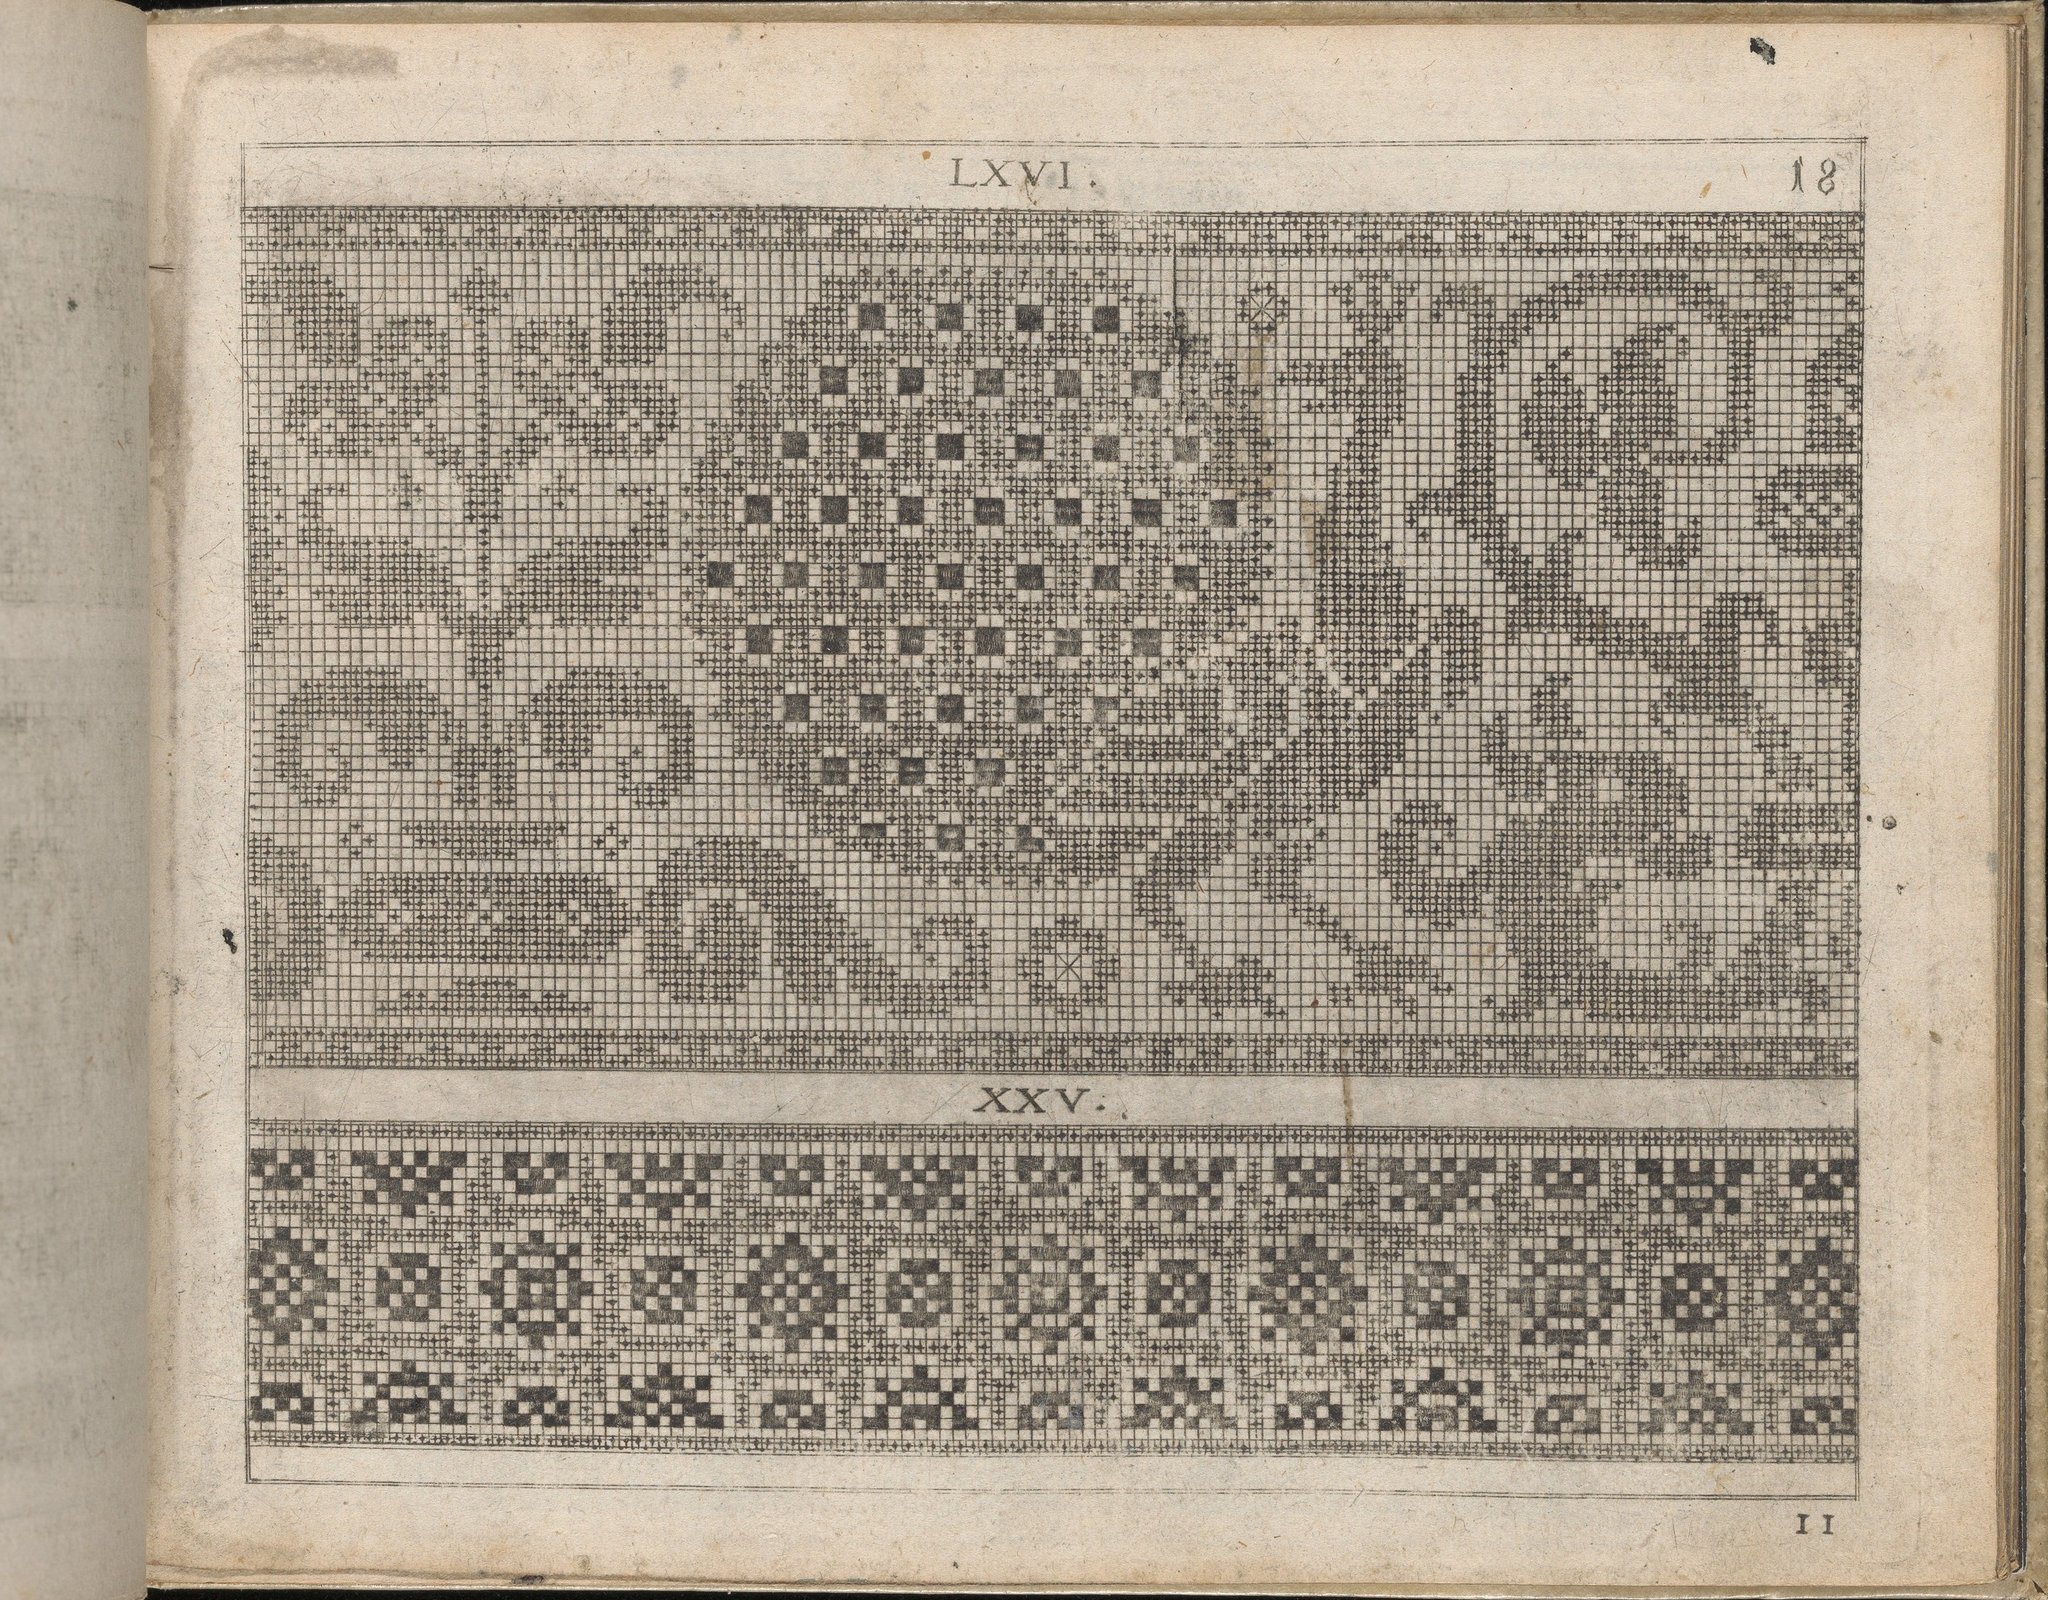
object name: book print ornament architecture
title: Newes Modelbuch in Kupffer (Page 27r)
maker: johann sibmacher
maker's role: artist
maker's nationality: german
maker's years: 1590-1611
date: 1604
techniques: etching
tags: ornament,peacocks